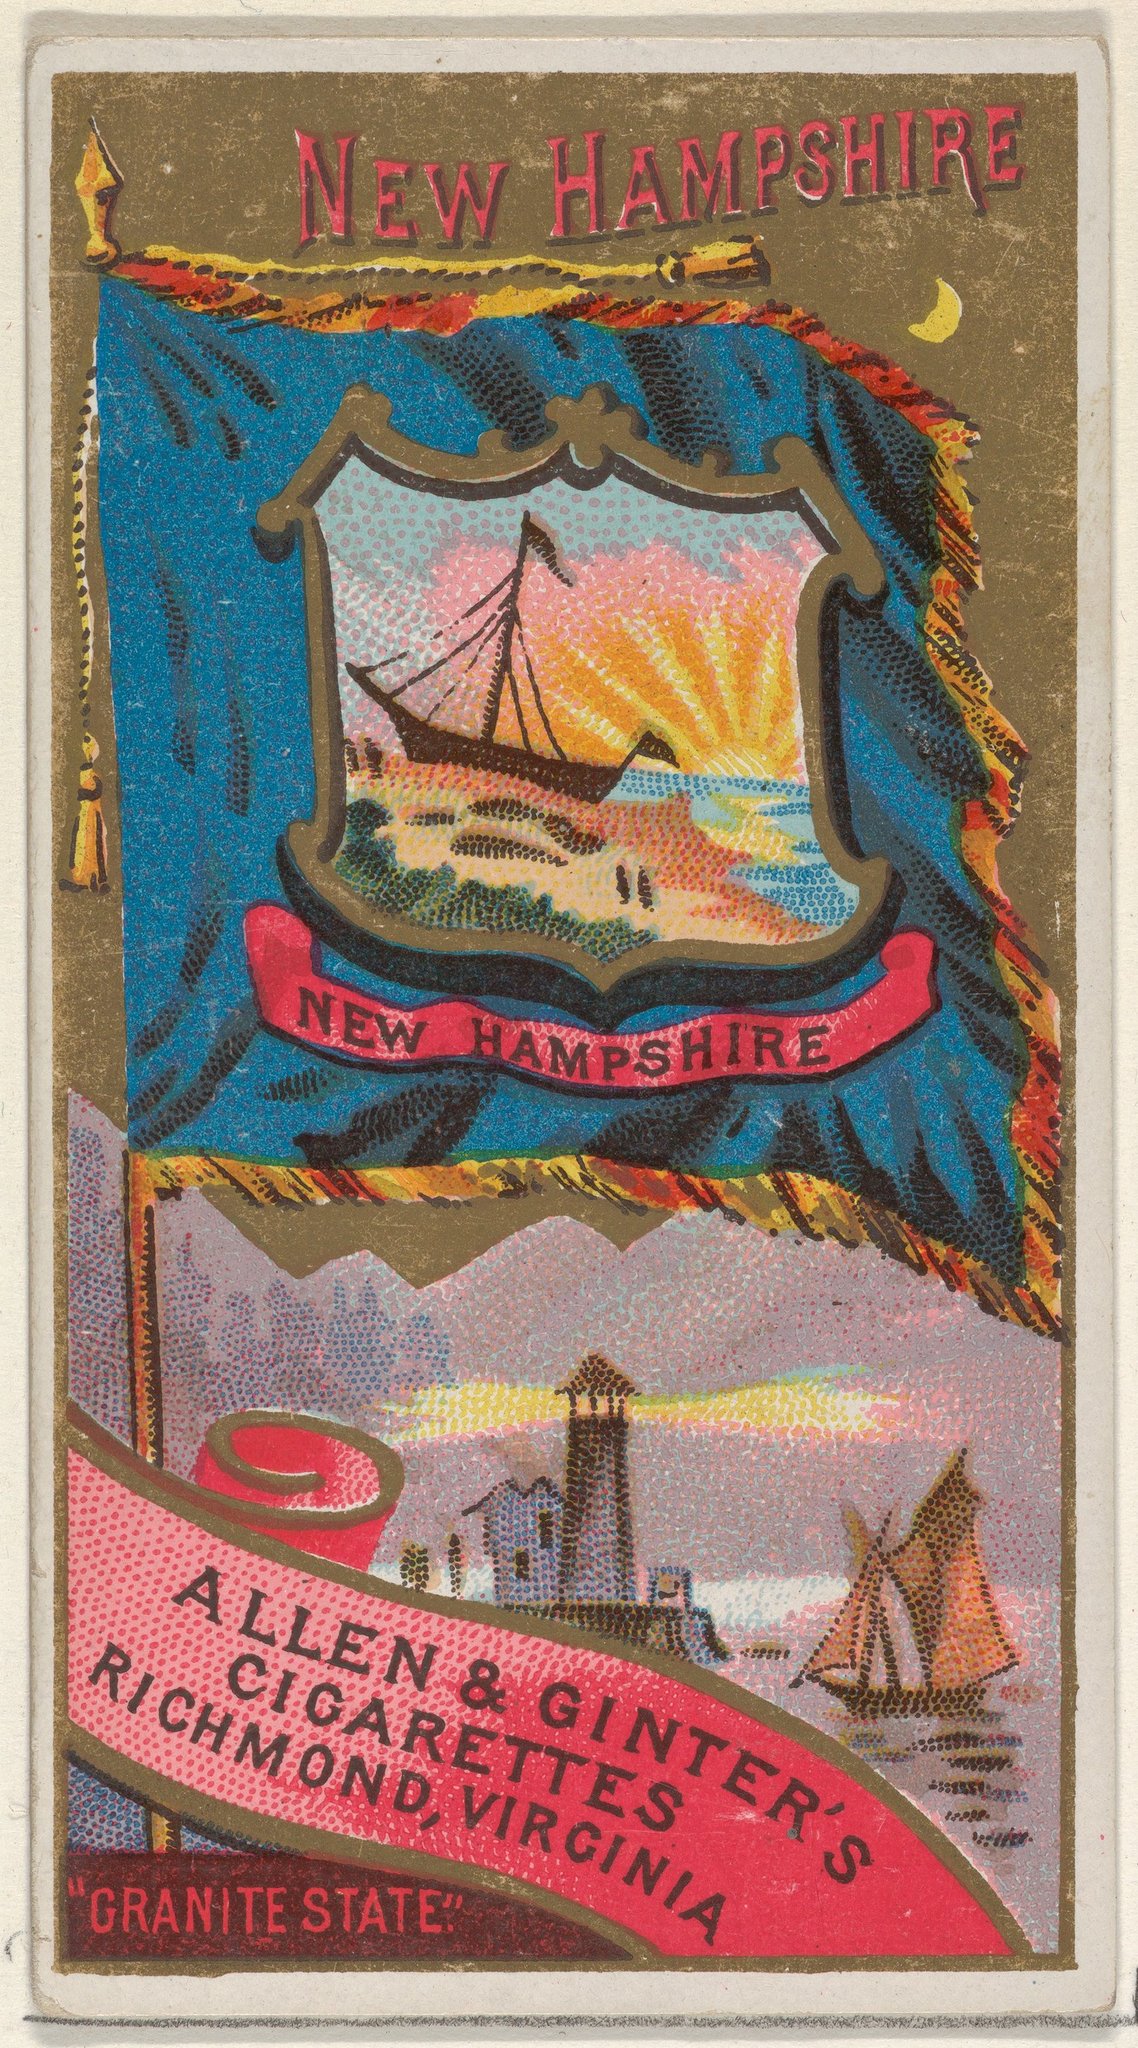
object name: print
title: New Hampshire, from Flags of the States and Territories (N11) for Allen & Ginter Cigarettes Brands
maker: allen & ginter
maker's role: publisher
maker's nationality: american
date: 1888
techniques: color lithograph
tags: flags